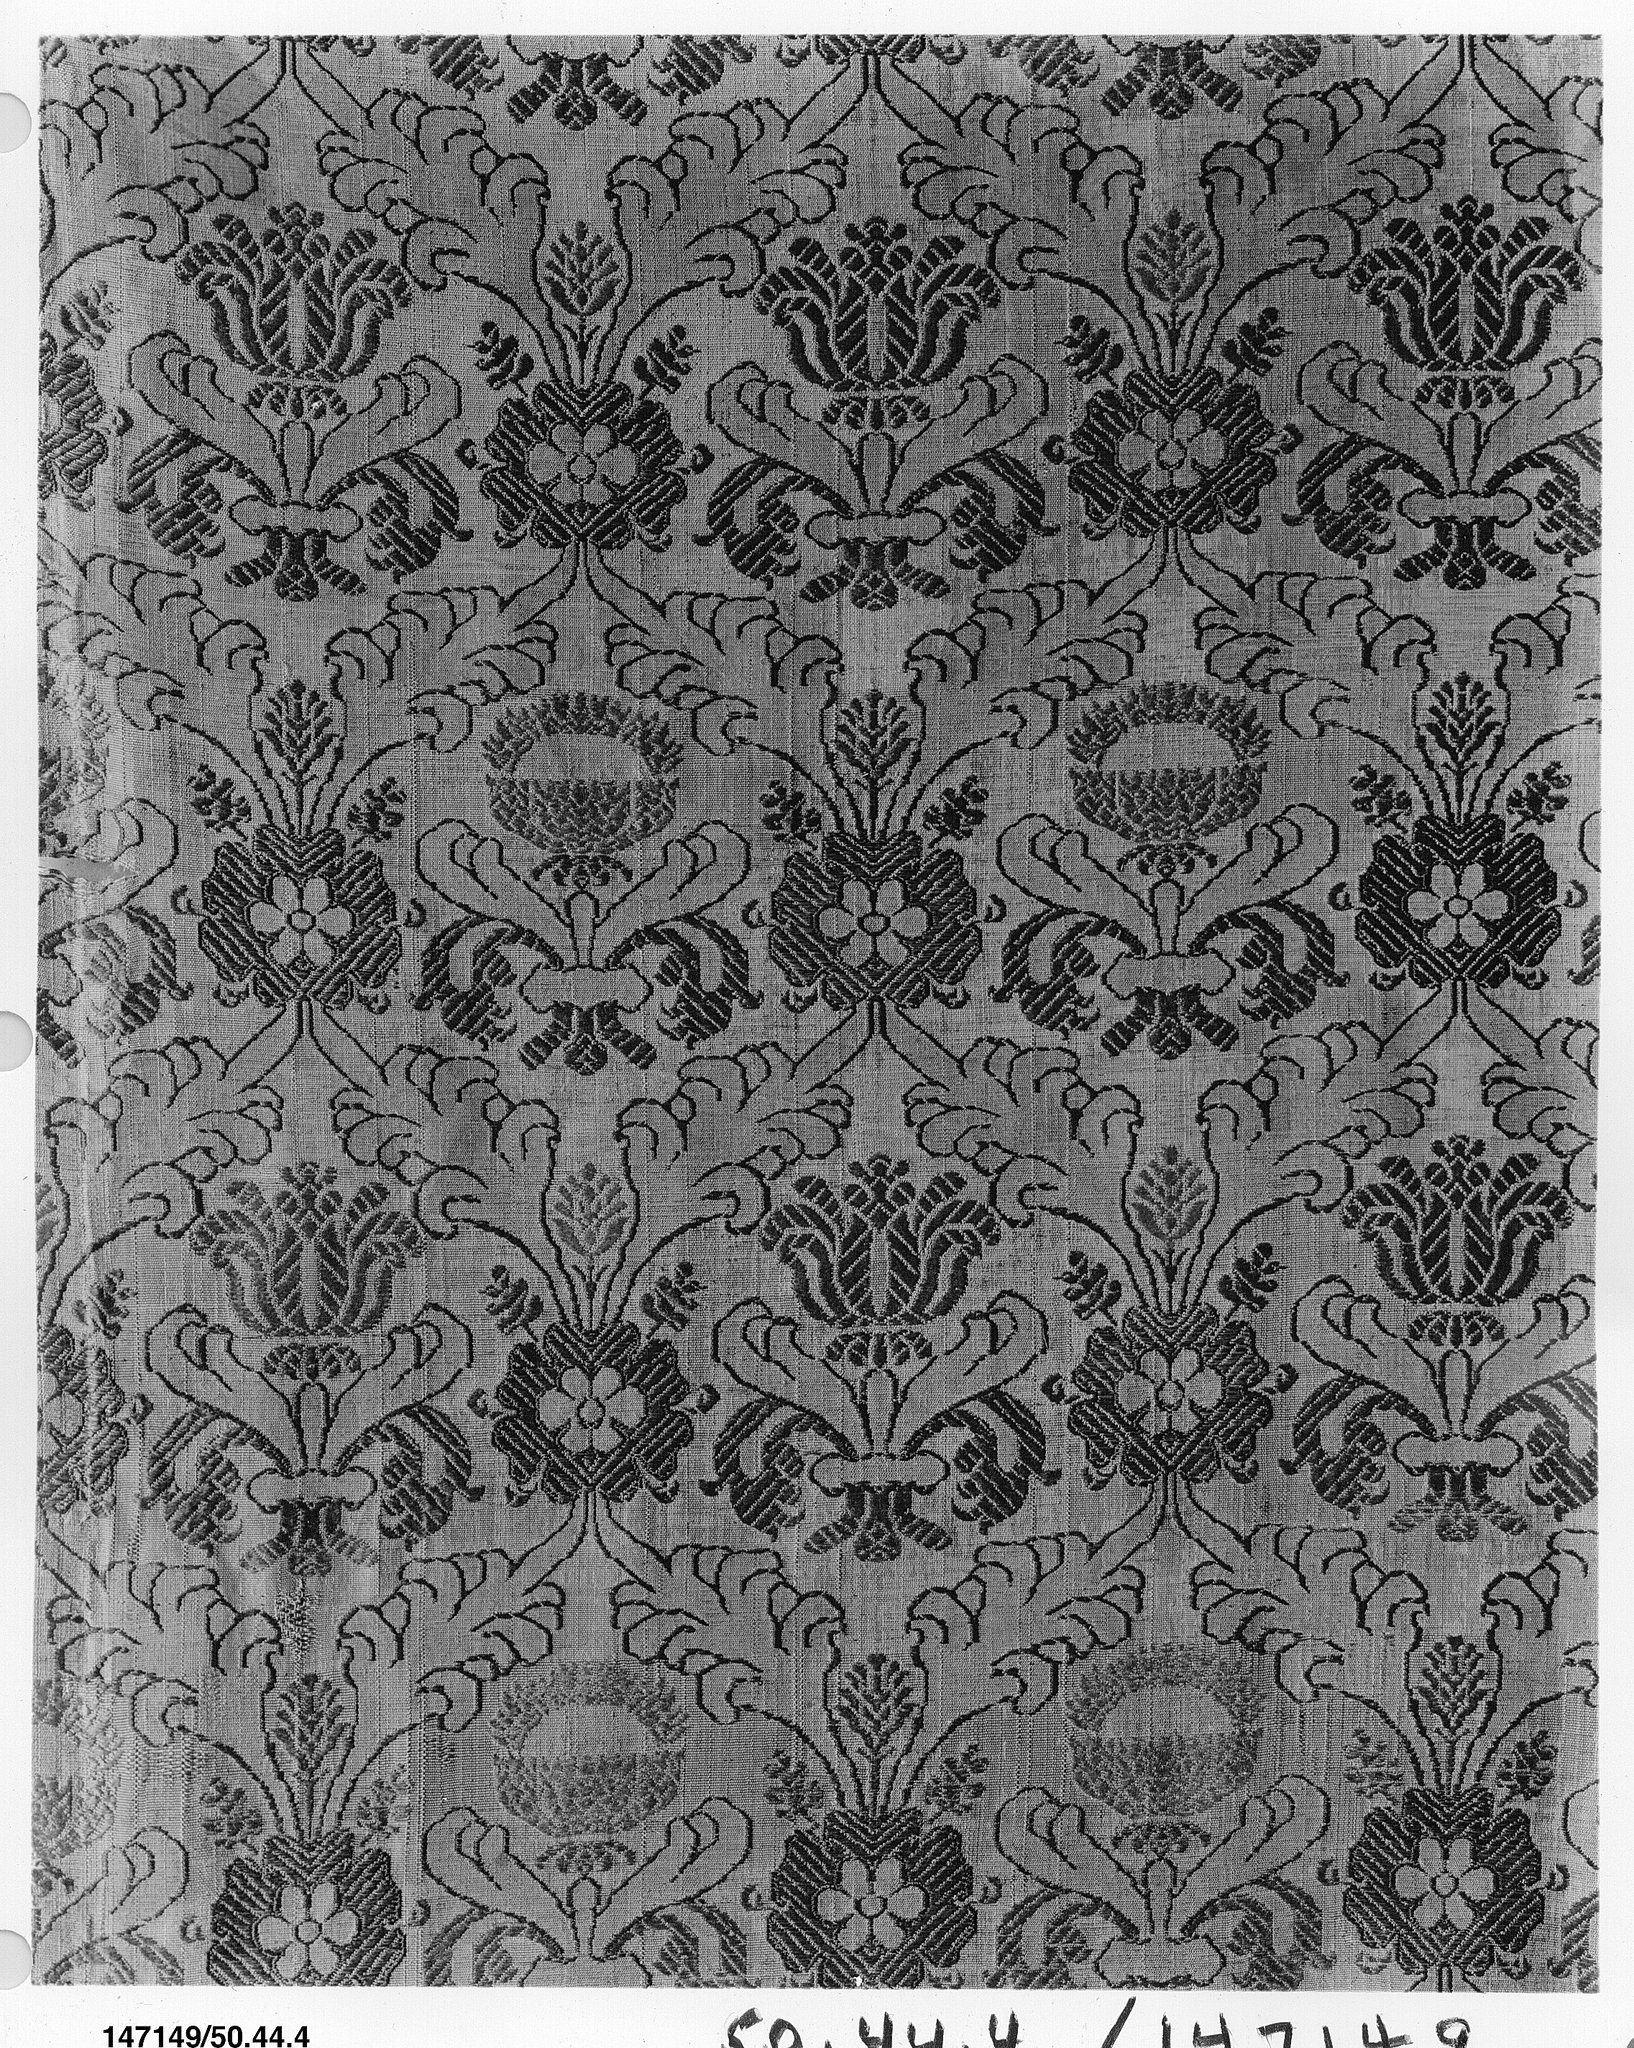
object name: piece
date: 1501-1600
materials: metal thread, silk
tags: flowers